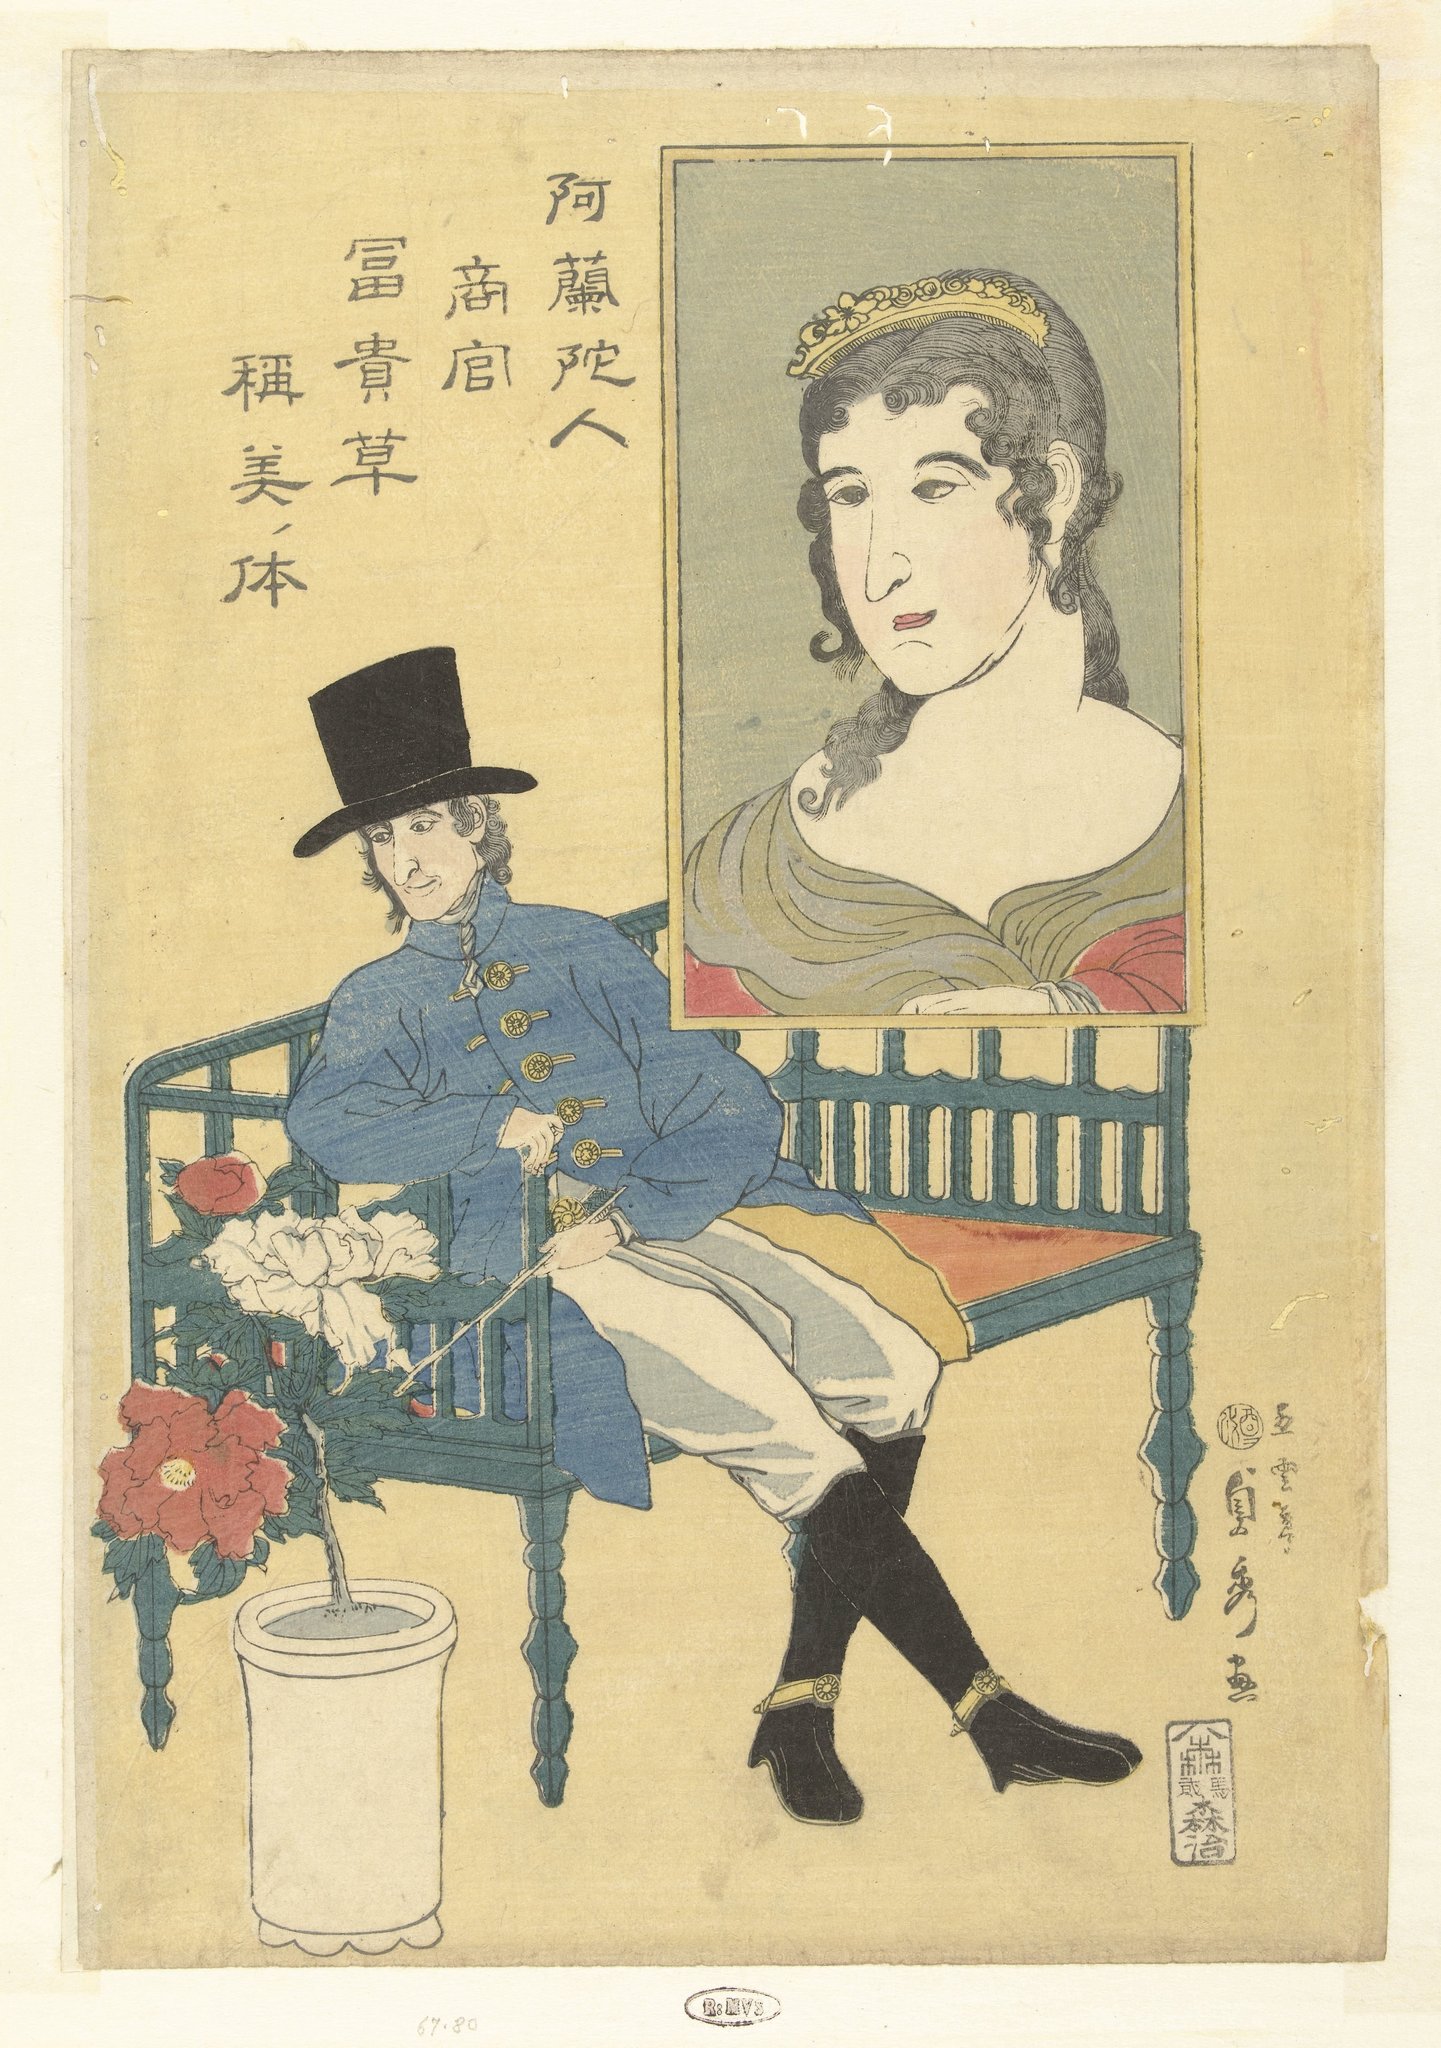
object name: print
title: Nederlandse handelsagent pioenrozen bewonderend als zijnde zijn vrouw.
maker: utagawa sadahide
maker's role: draughtsman, print maker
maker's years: 1807-1873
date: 1861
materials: paper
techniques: woodcut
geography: tokyo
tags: flowers: peony, happy marriage, europeans (with name), merchant, salesman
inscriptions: collector's mark: Lugt 2228